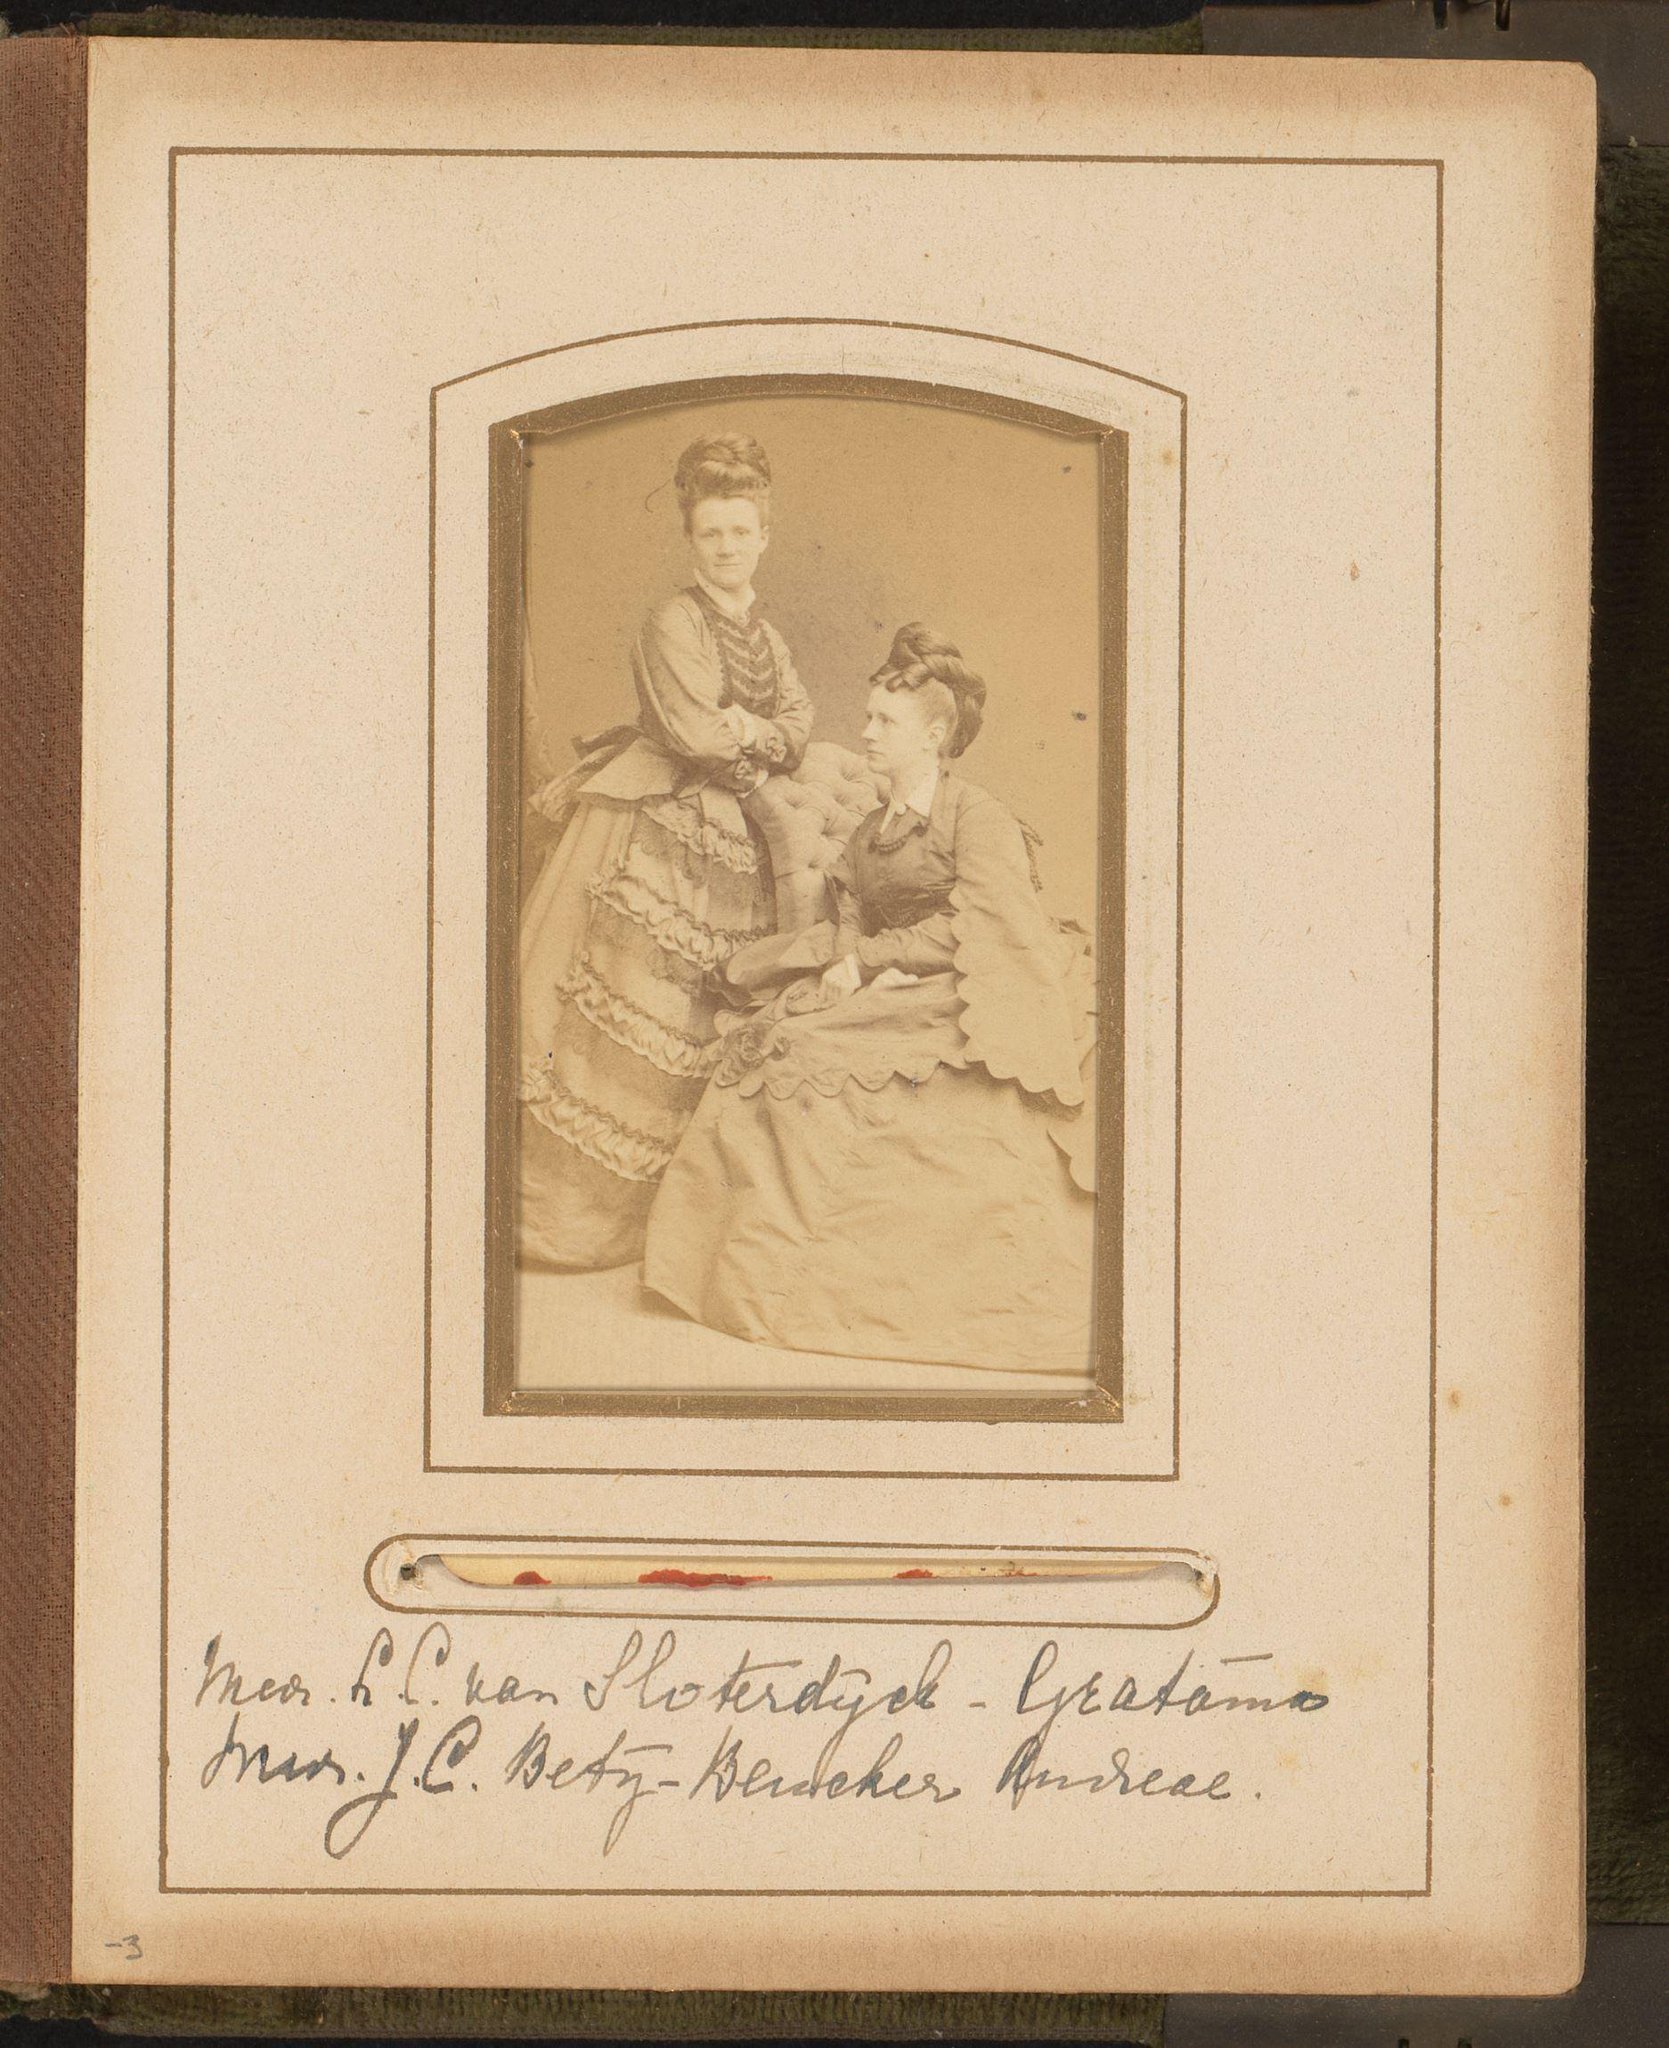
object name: photograph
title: Dubbelportret van Johanna Cornelia Betz-Beucker Andreae en een vrouw, aangeduid als L.C. van Sloterdijck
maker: Anonymous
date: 1900-1914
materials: cardboard, paper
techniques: albumen print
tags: the hague, adult woman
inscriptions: inscription: ‘Mevr. L.C. van Sloterdijck-[...]/ Mevr. J.C. Betz-Beucker Andreae.’